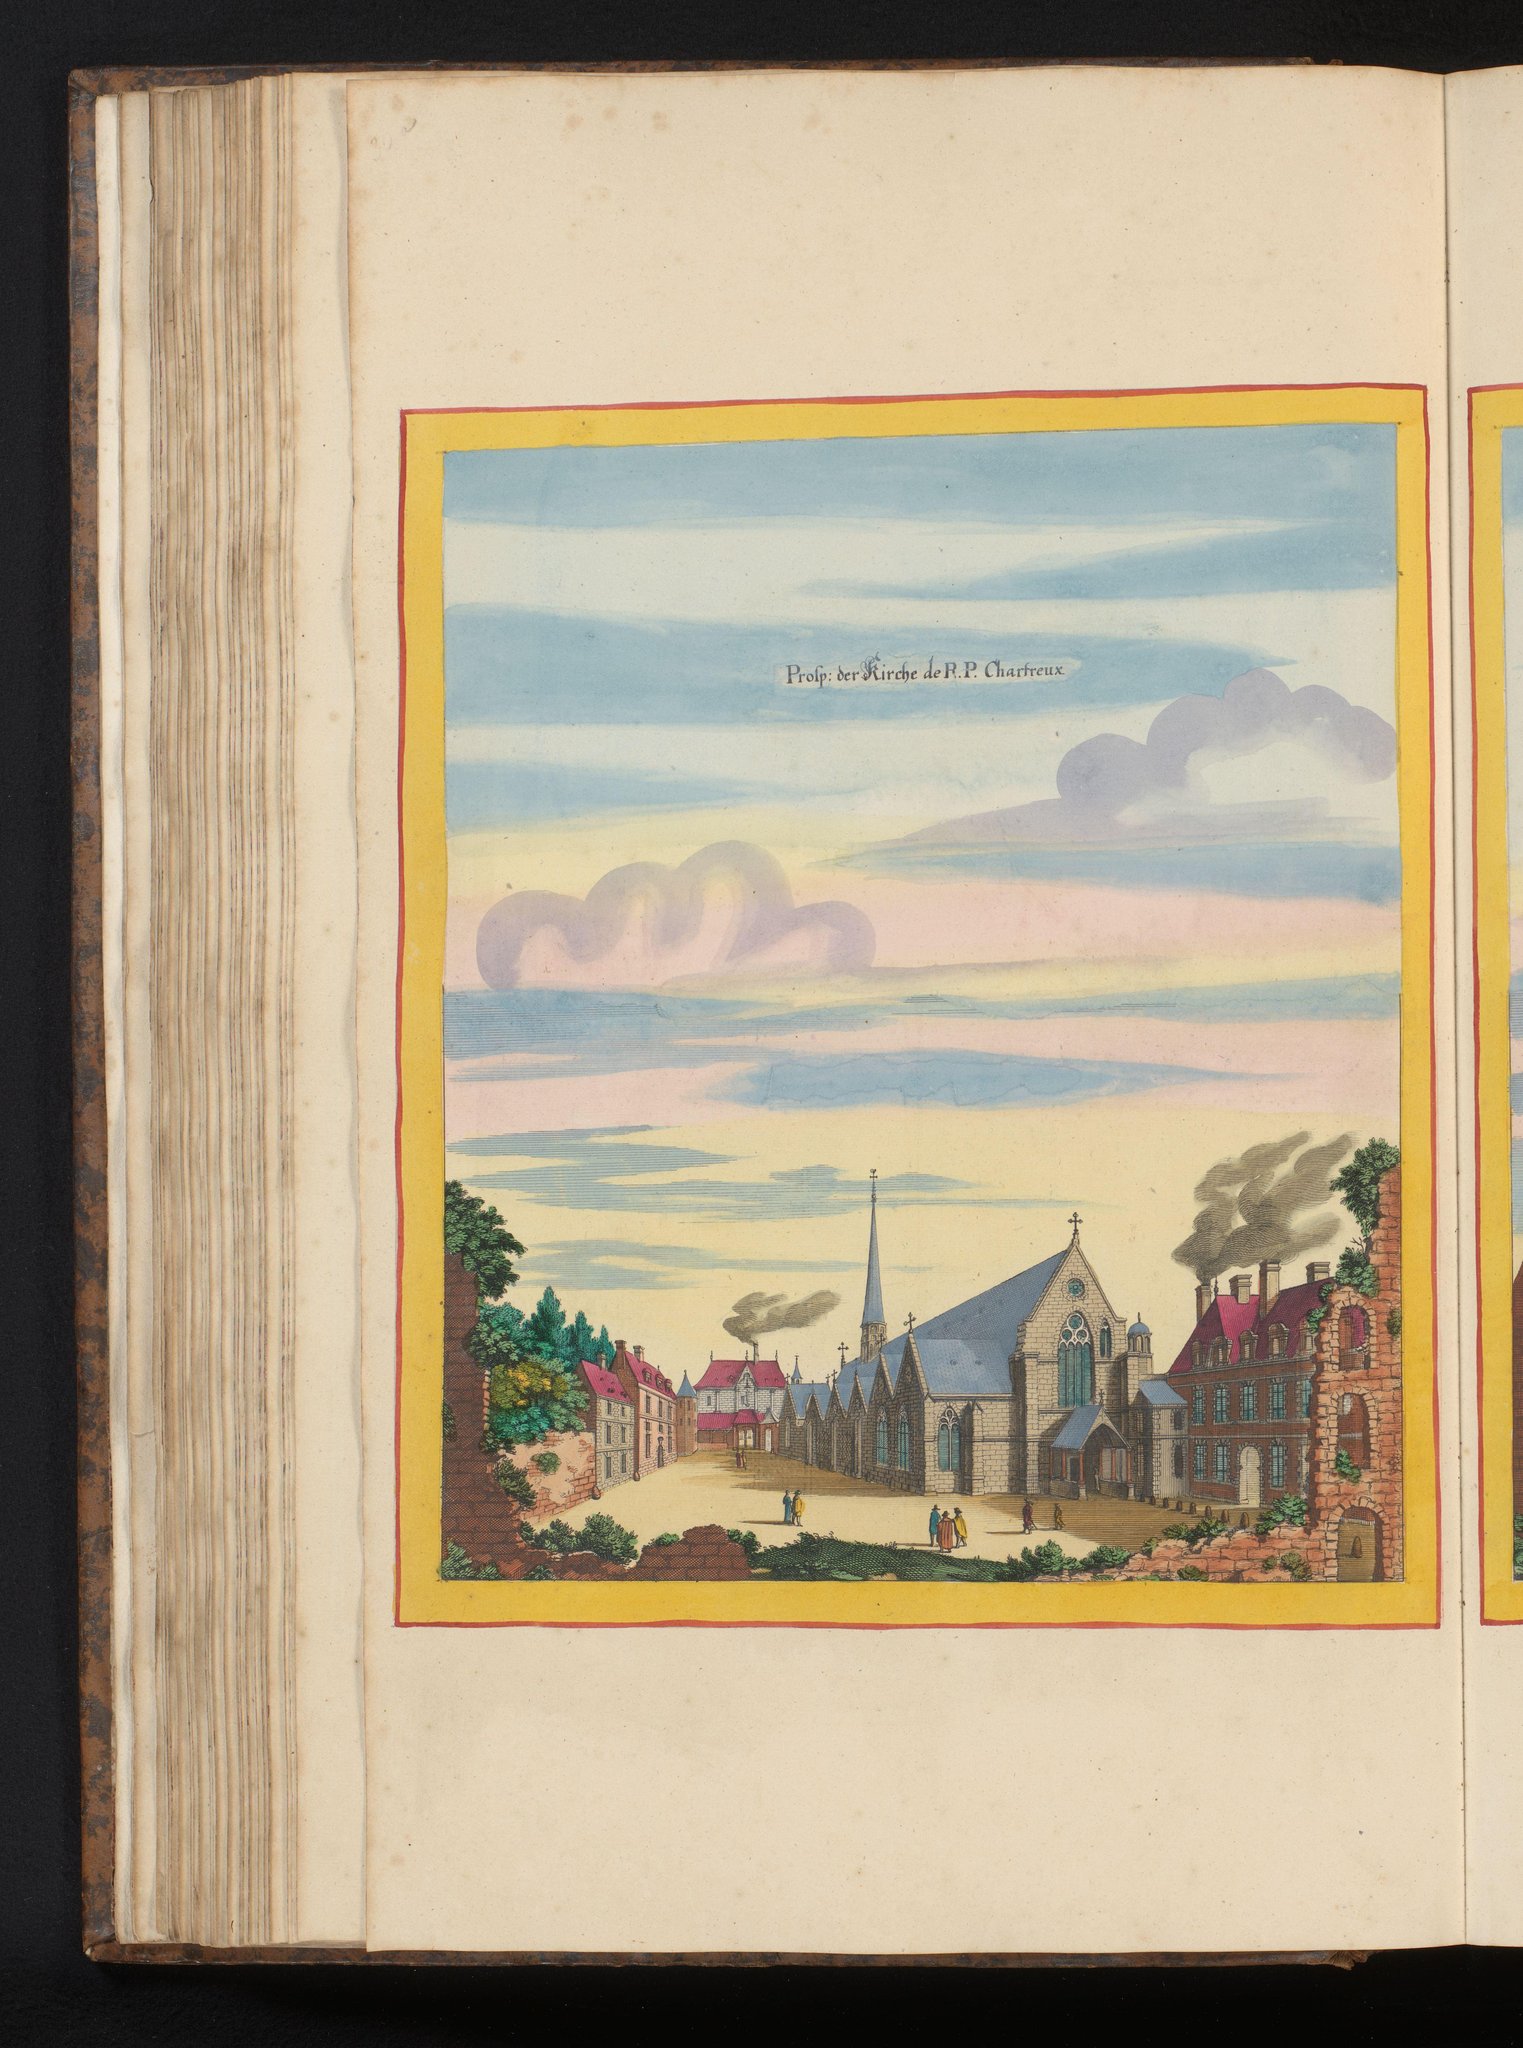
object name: album leaf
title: Gezicht op de Karthuizer kerk te Parijs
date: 1655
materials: paper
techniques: engraving, etching, hand coloring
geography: the hague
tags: church (exterior)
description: Prent origineel vervaardigd als boekillustratie voor: Zeiller, Martin. Topographia Galliae, oder Beschreibung und Contrafaitung der vornehmbsten und bekantisten Oerter in dem mächtigen und grossen Königreich Frankreich, 13 delen. Frankfurt am Main: Caspar Merian, 1655-1661. De prent werd voor het eerst gepubliceerd in deel 1: Topographia Galliae, 1655.